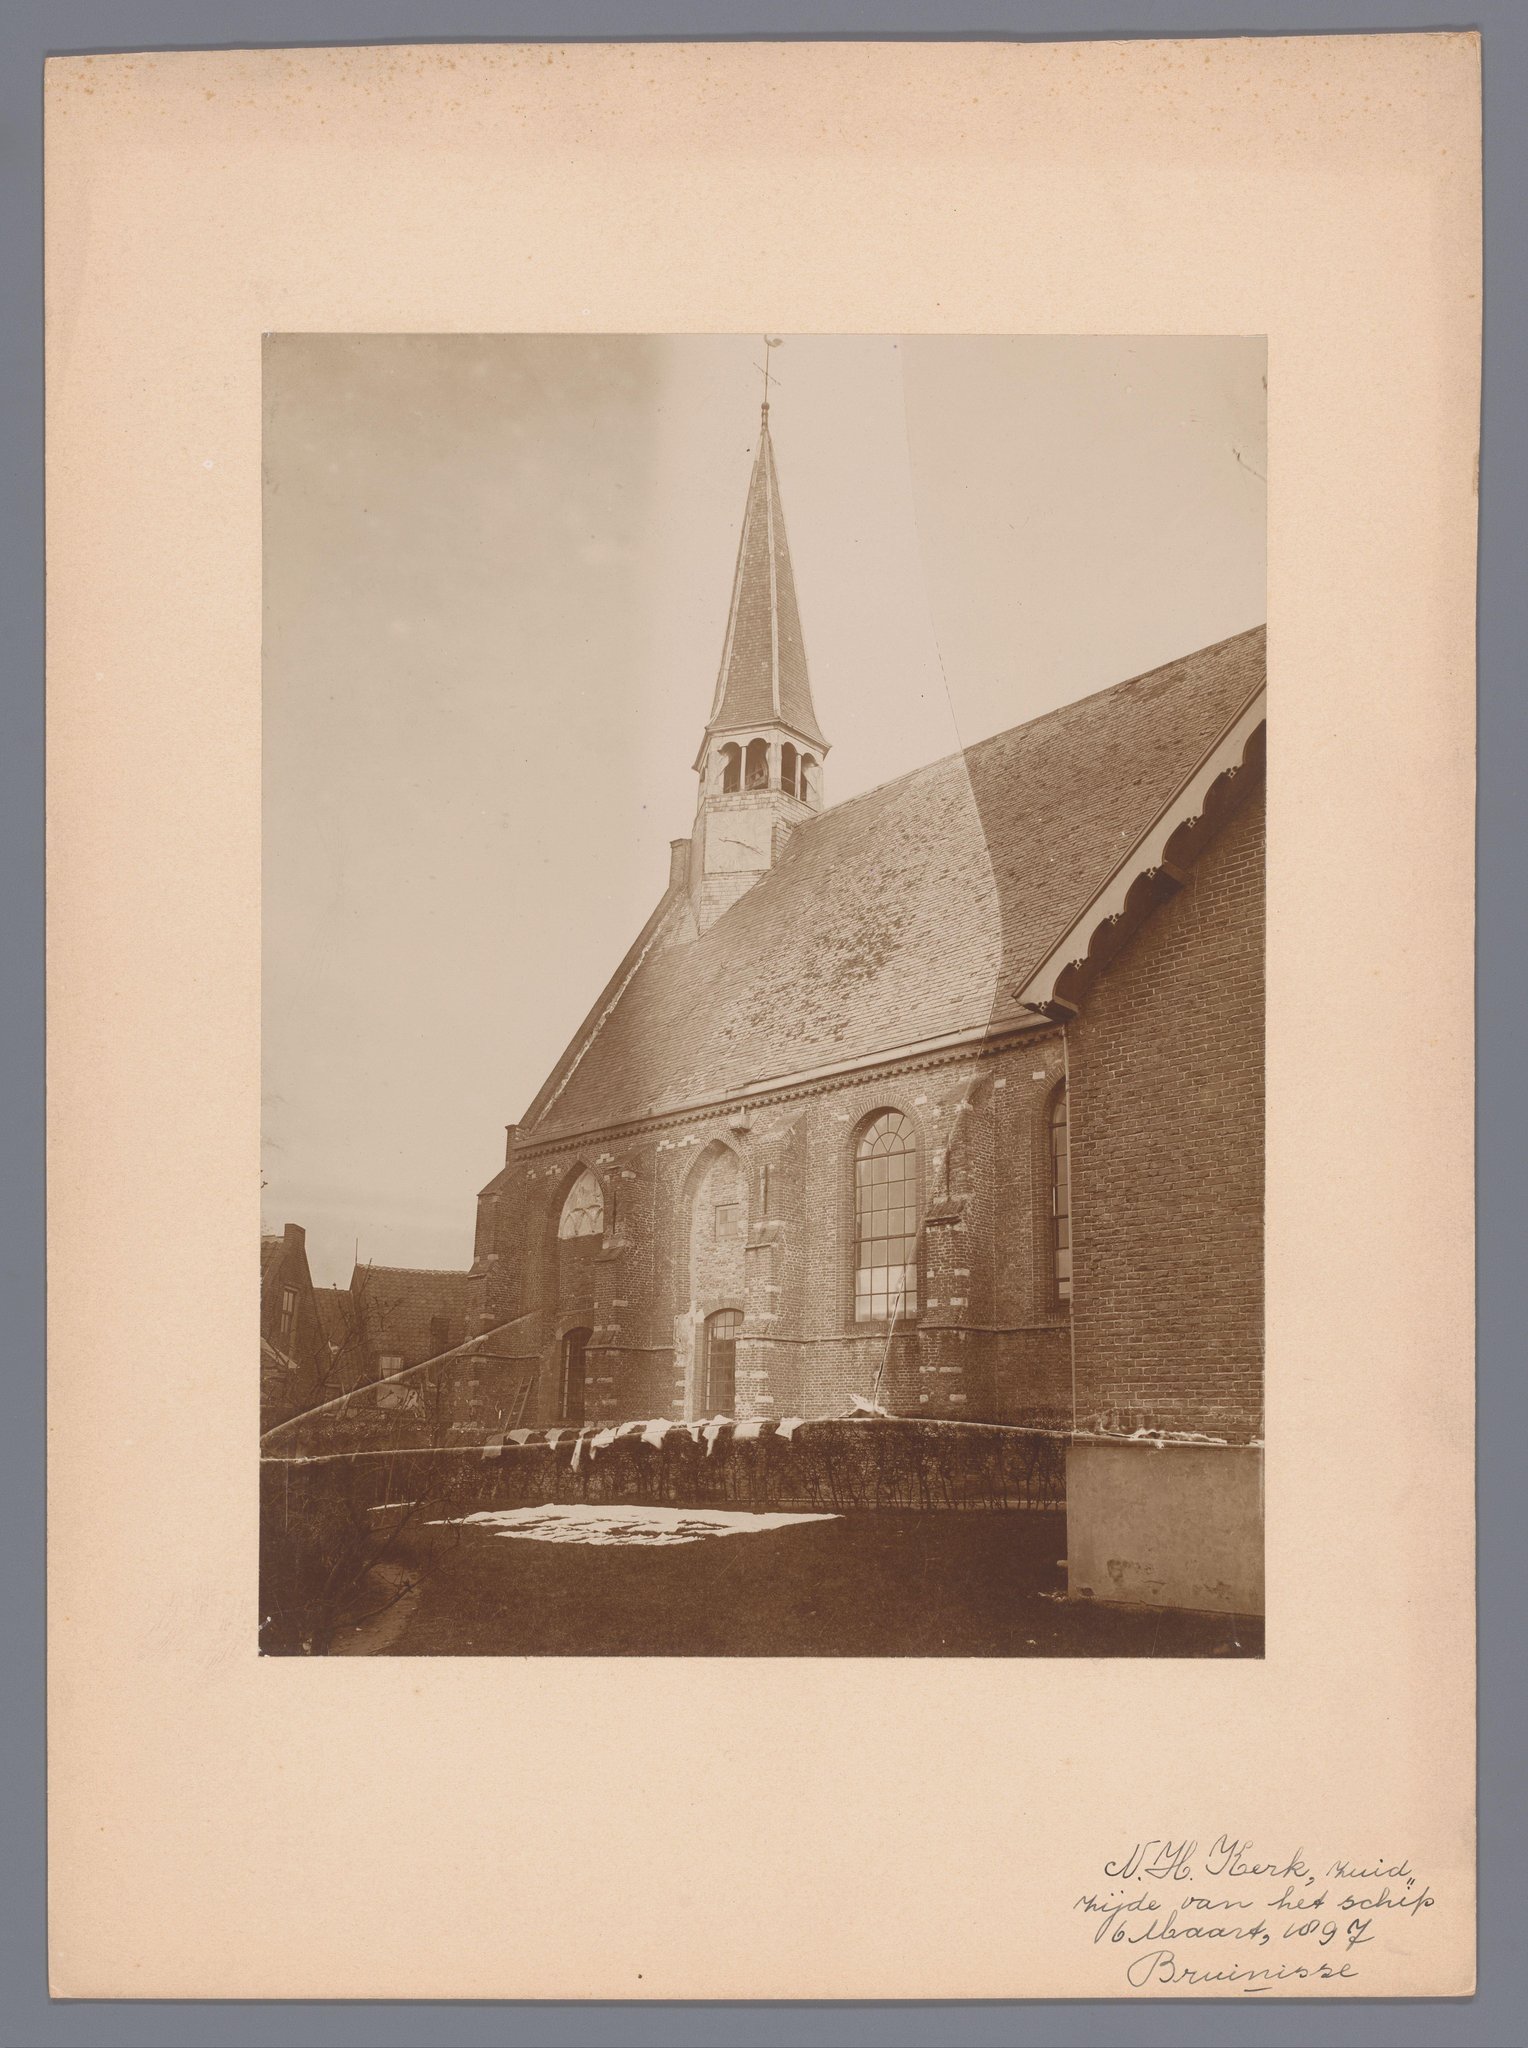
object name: photograph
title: Gezicht op de Hervormde Kerk te Bruinisse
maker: anoniem (monumentenzorg)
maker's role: fotograaf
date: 1897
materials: cardboard, photographic support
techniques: collodion silver print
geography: bruinisse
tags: church (exterior)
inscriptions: annotation: ‘N.H. Kerk, zuidzijde van het schip/ 6 Maart 1897/ Bruinisse’, annotation: ‘Bruinisse (Z.)/ N.H. Kerk (Zuidzijde v/h schip)/ 6 Maart 1897’